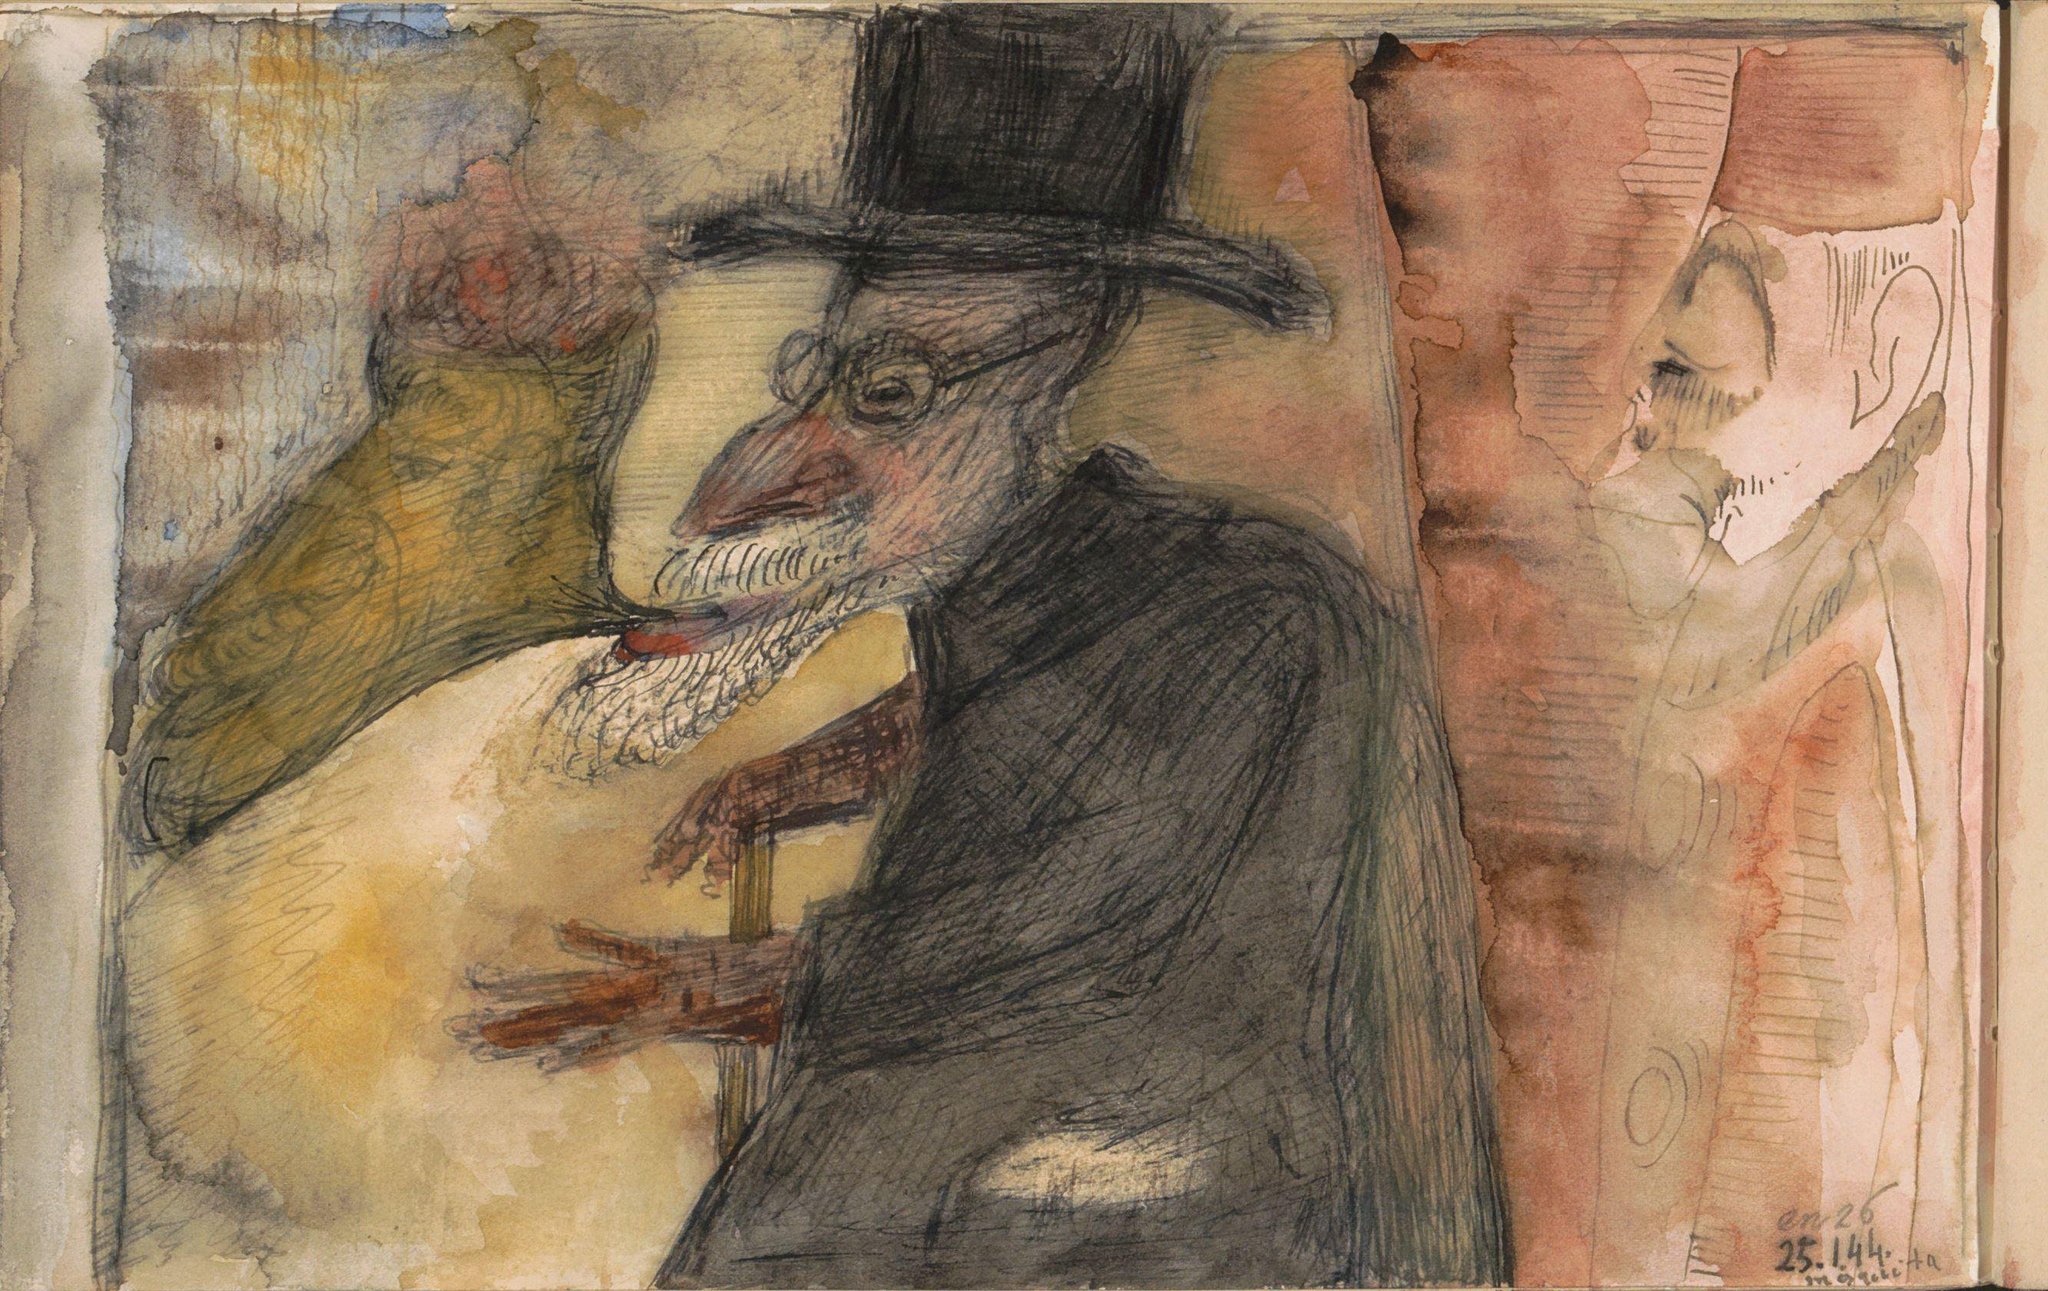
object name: sketchbook leaf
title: Man met een baard, wandelstok en hoge hoed, in profiel naar links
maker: samuel jessurun de mesquita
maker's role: draughtsman, print maker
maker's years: 1868-1944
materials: ink, paper, watercolor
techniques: brush, pen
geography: amsterdam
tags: head (human), walking-stick, staff, adult man, beard, head-gear: top hat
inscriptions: signature and date: ‘en 26/ 25.1.44./ mesquita’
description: De man ademt een wolk uit die de vorm heeft van zijn eigen hoofd. Tevens rechts van de man een man met een hoed, in profiel naar links. Blad 18 verso uit een schetsboek met 18 bladen.